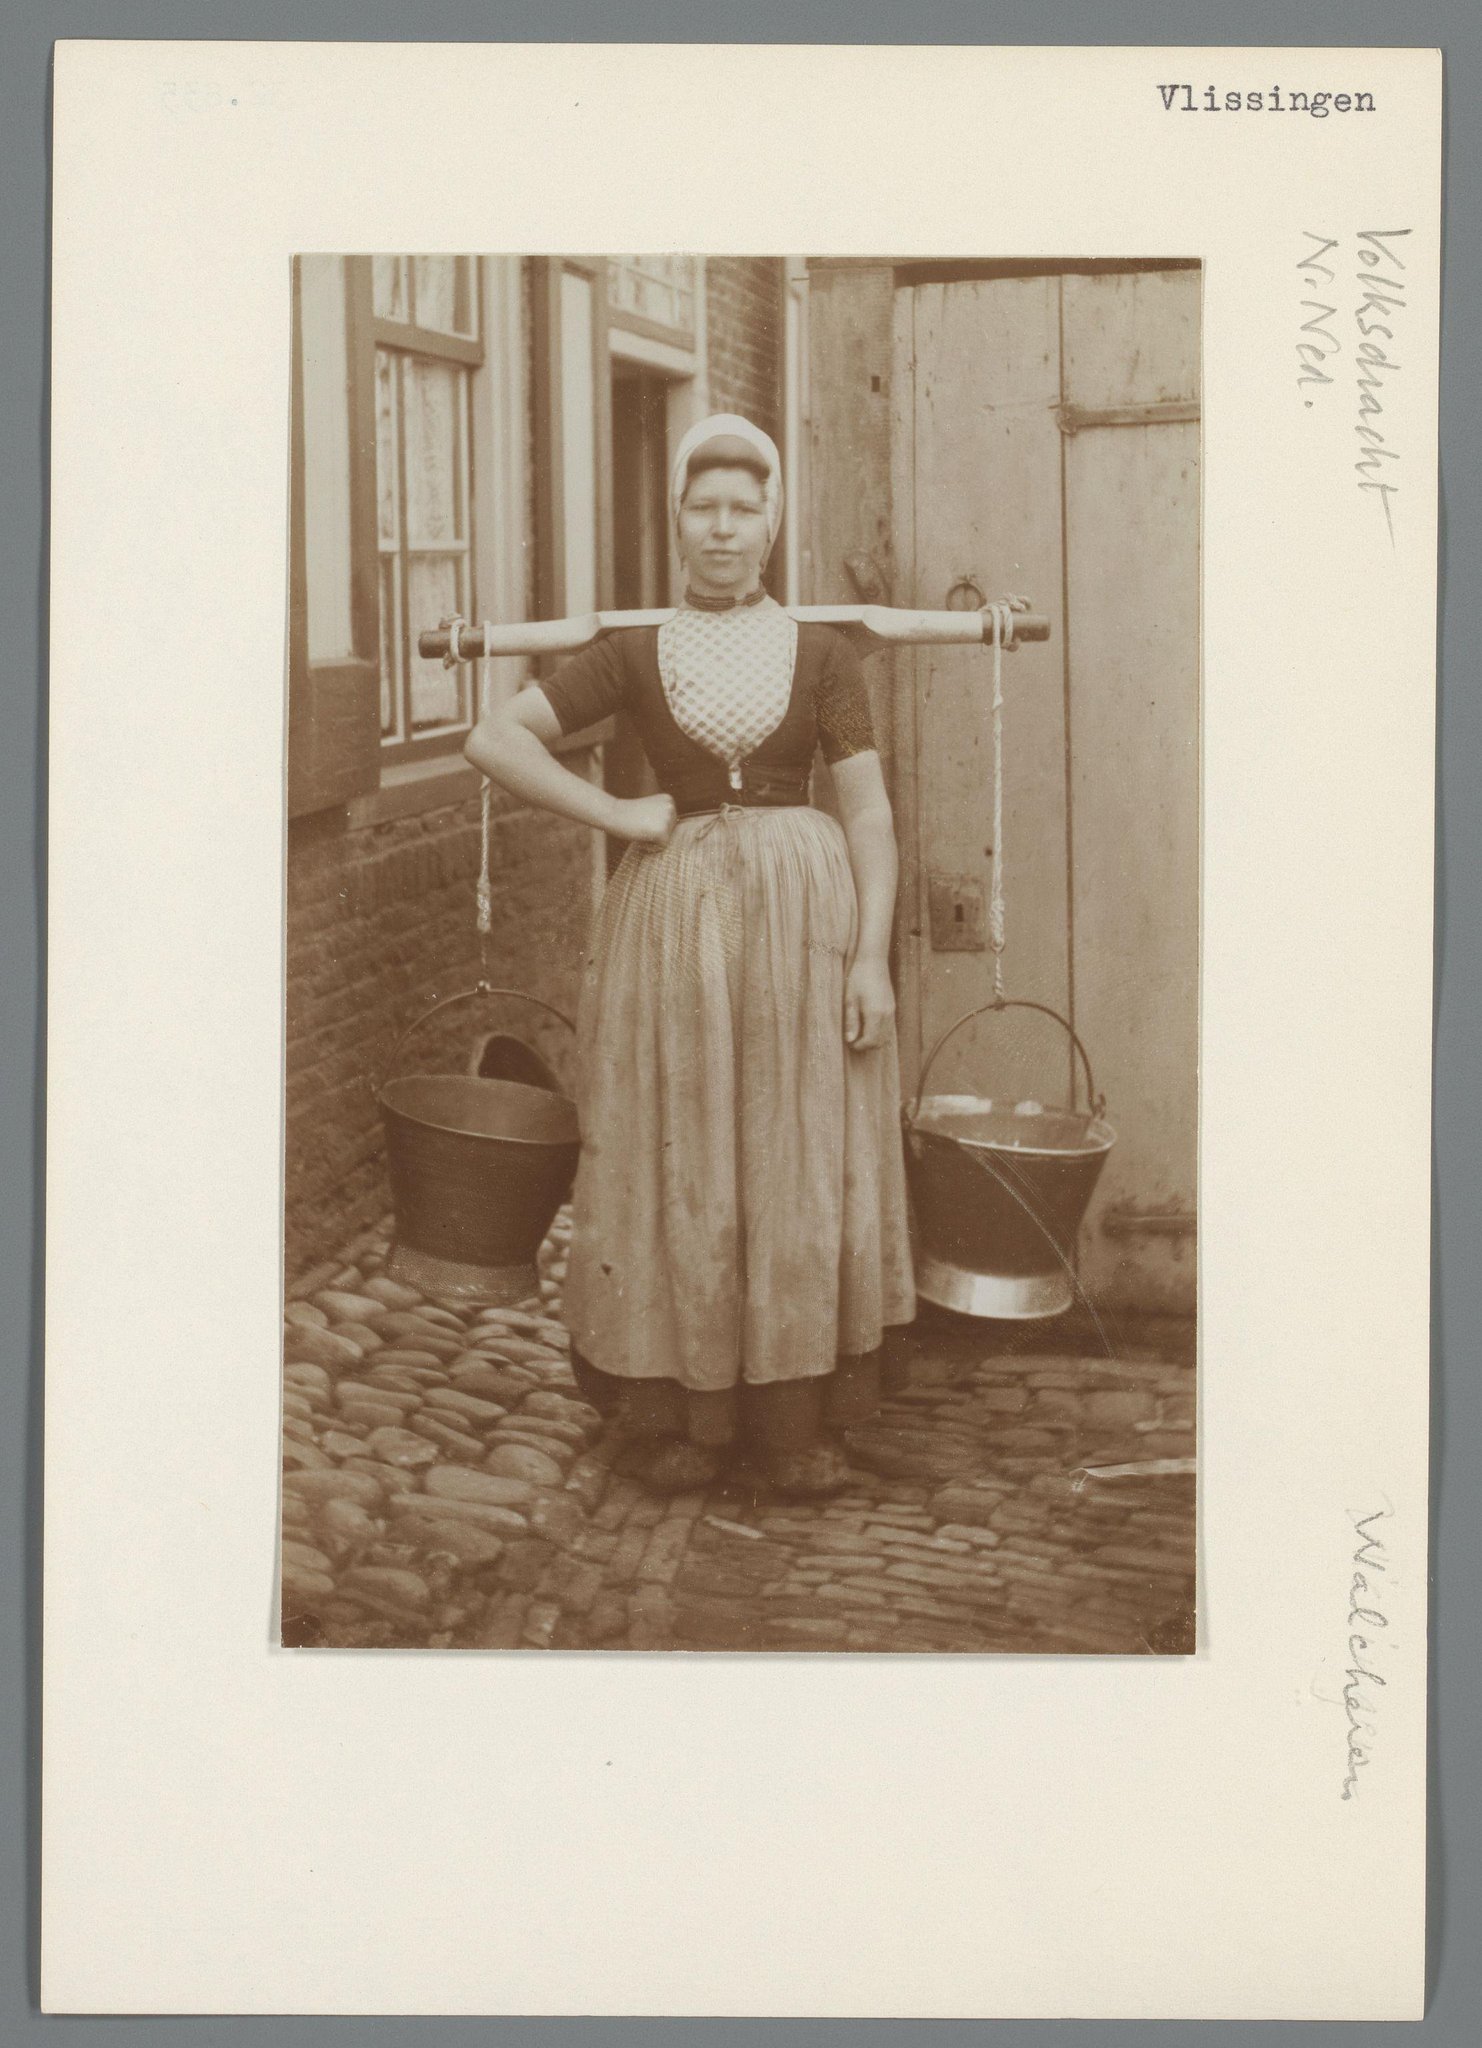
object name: photograph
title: Vlissingen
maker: Anonymous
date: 1880-1920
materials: paper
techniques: collodion silver print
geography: flushing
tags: historical persons, carrying something with yoke, folk costume, regional costume, flushing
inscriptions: inscription: ‘Volksdracht/ N.Ned./ Walcheren’, number: ‘- 527078’, number: ‘32.835’